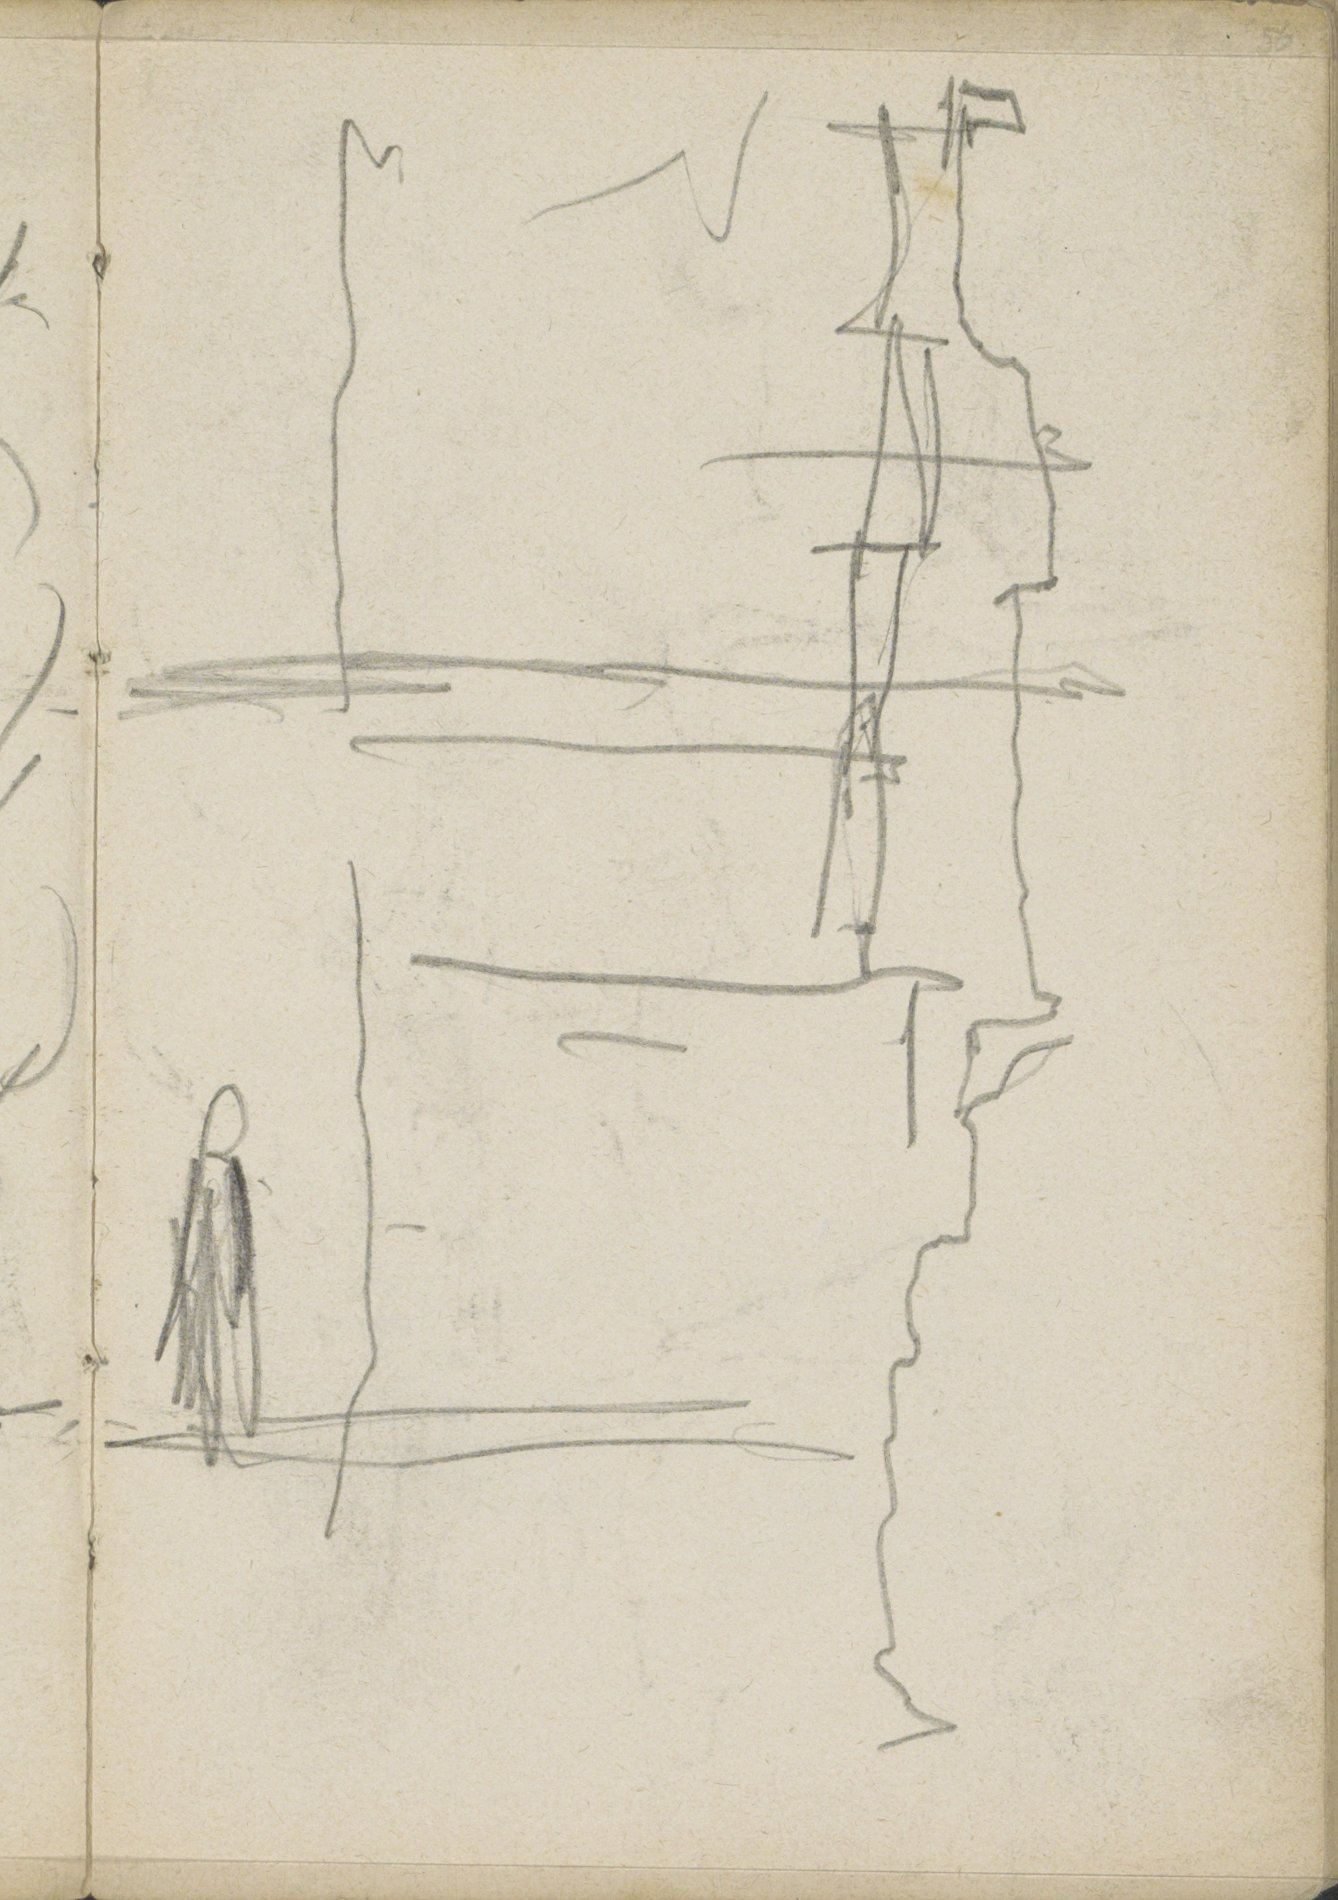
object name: sketchbook leaf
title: Gezicht op gebouwen aan het Damrak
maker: george hendrik breitner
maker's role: draughtsman, painter, print maker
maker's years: 1857-1923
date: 1900-1901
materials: paper, pencil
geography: amsterdam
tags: urban housing, canals, waters (in city)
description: Gezicht op gebouwen aan het Damrak. Pagina 56 uit een schetsboek met 46 bladen vervaardigd te Amsterdam.